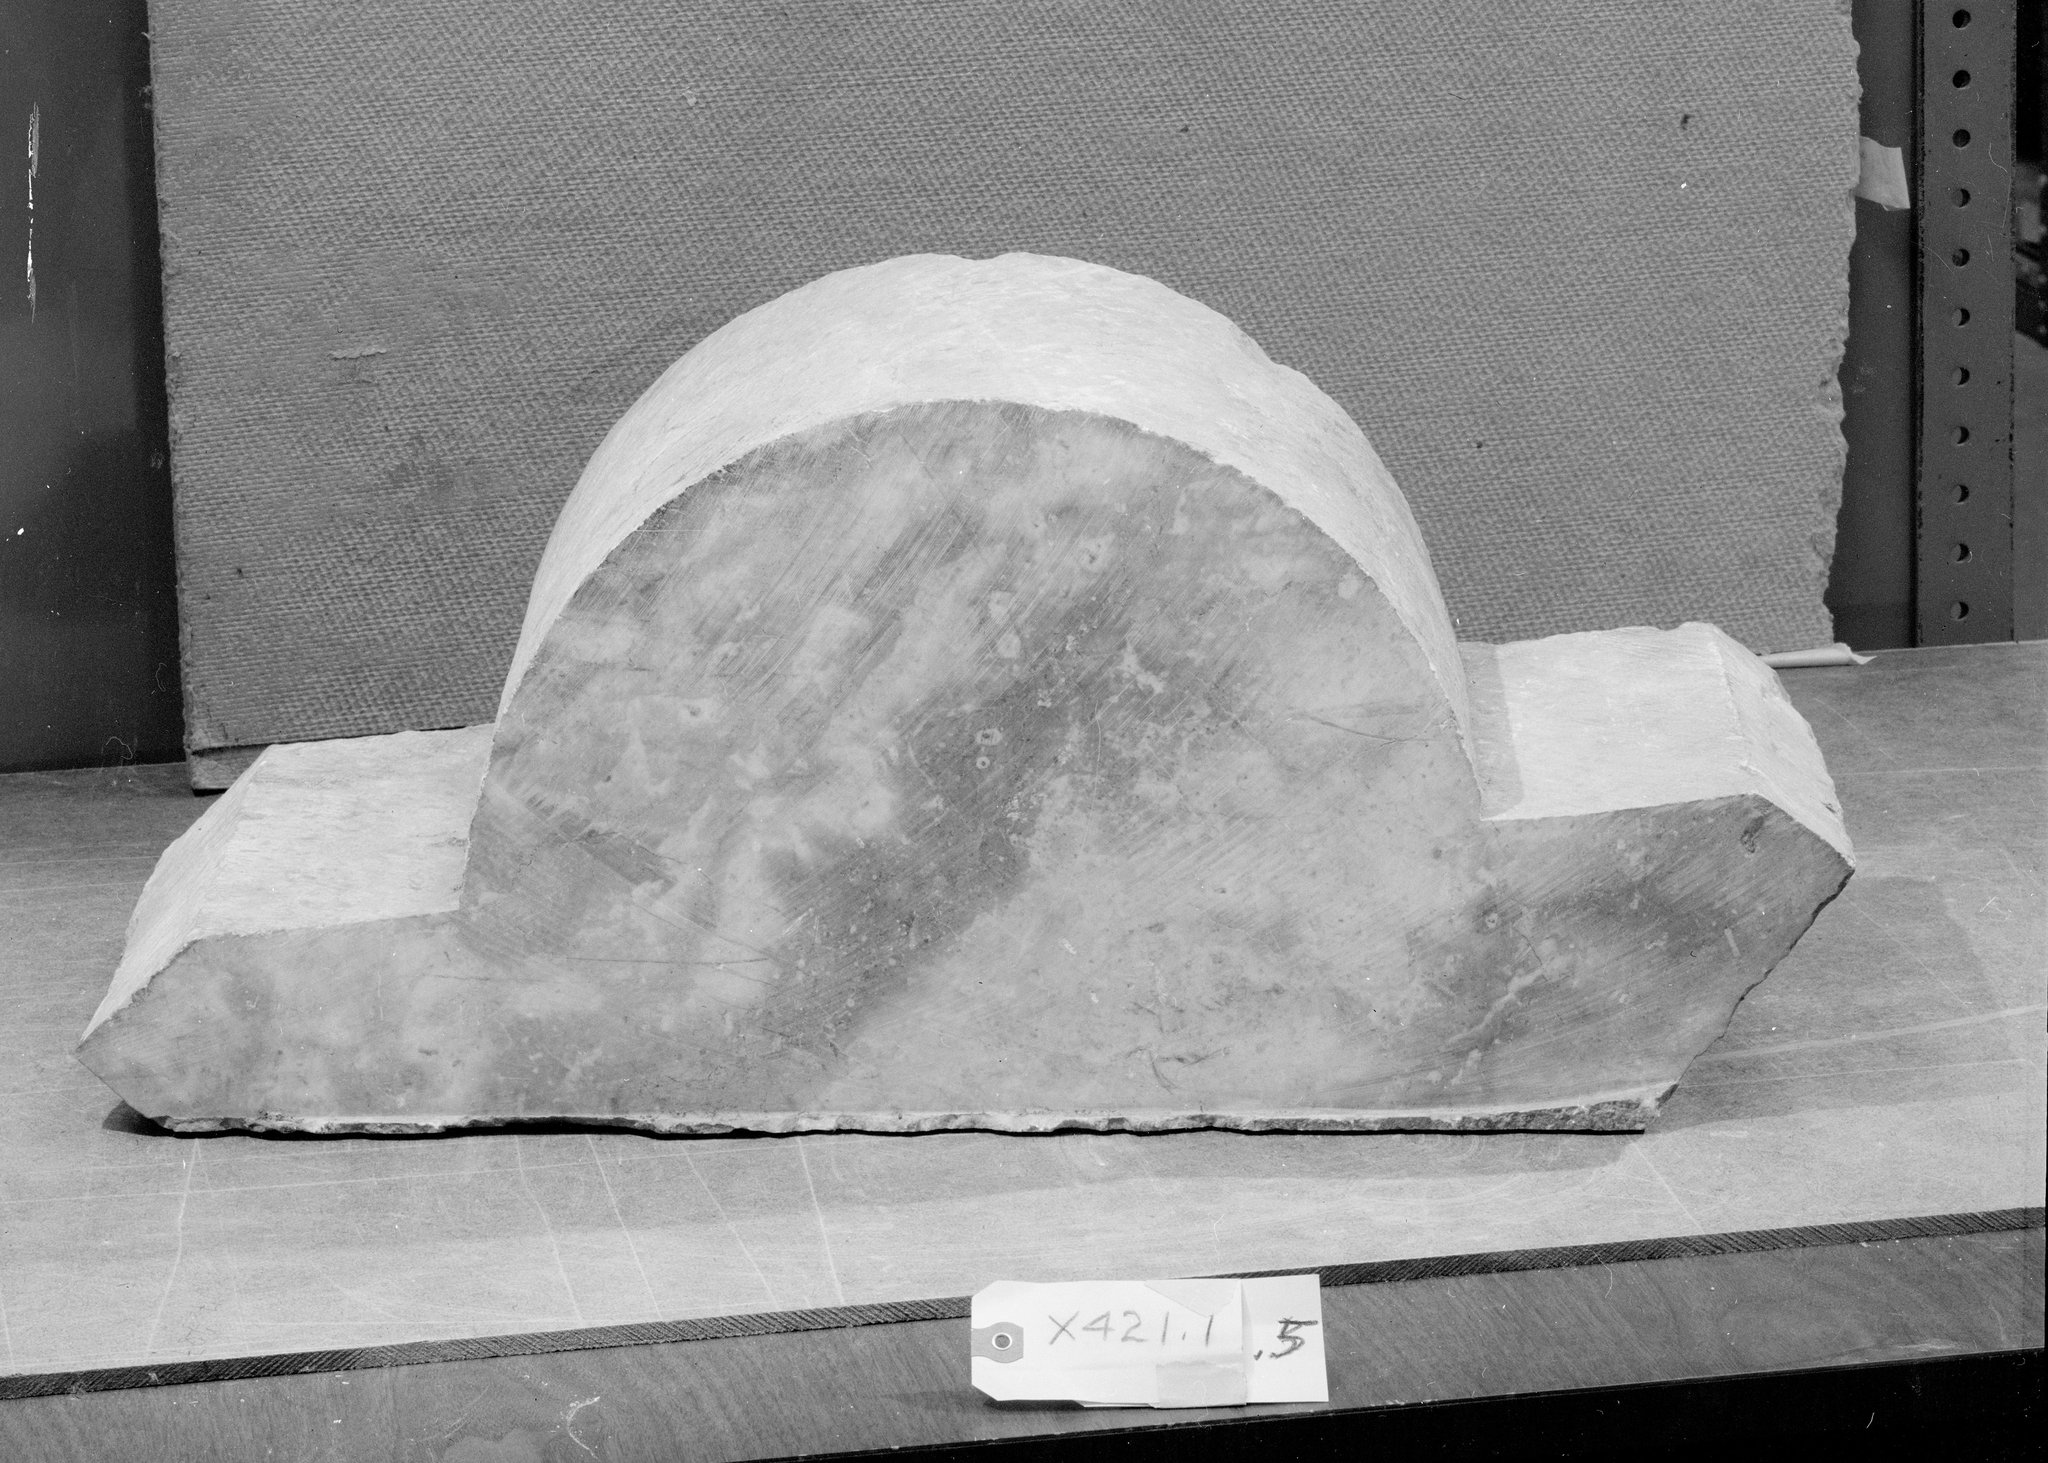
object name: shaft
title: Engaged Shaft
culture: french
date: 1130-1140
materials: stone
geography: france